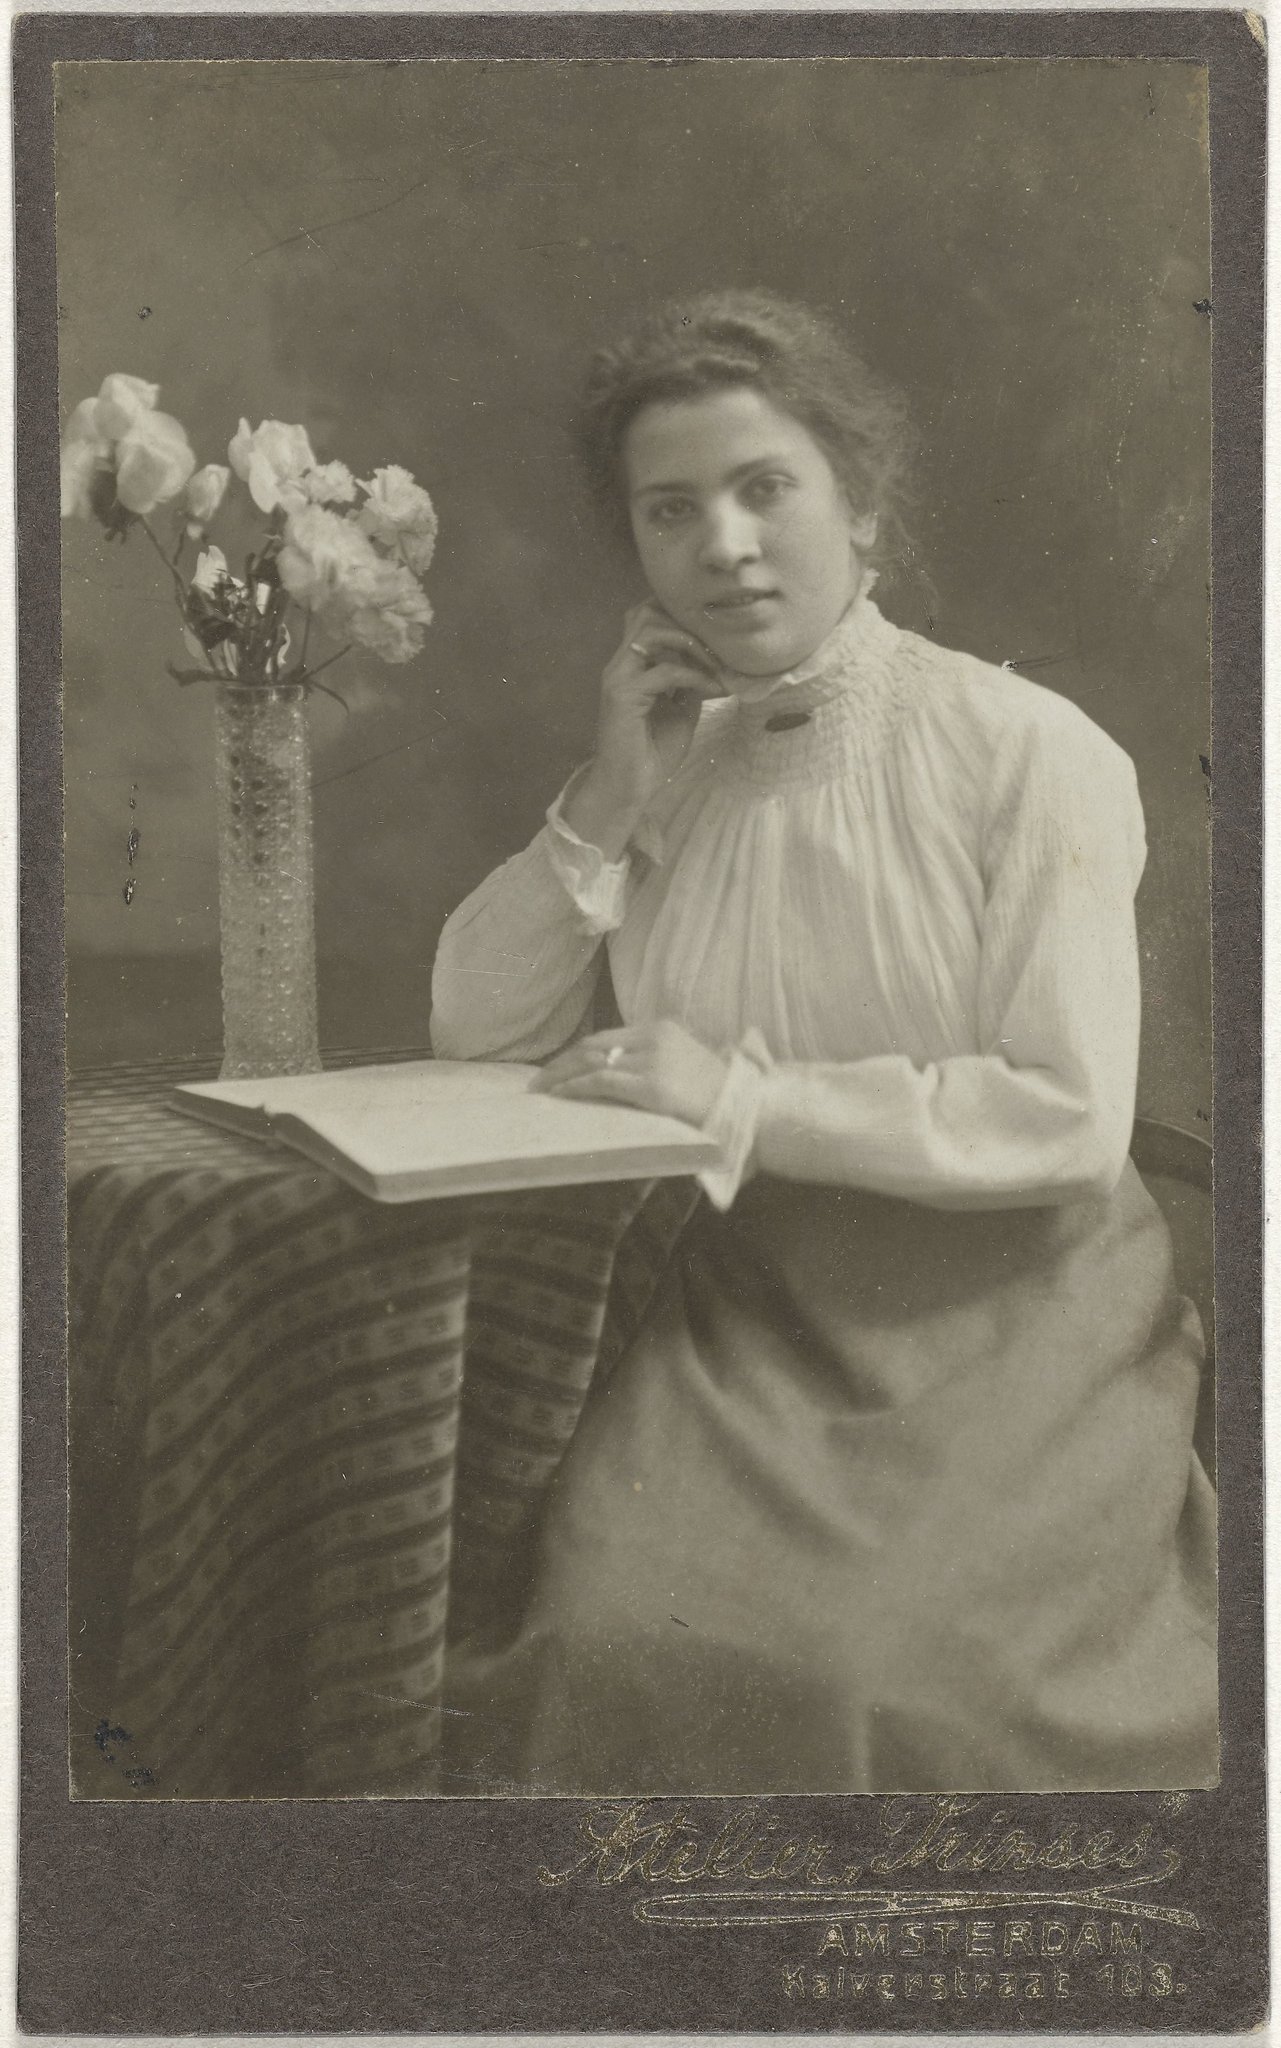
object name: photograph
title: Studioportret van jongedame in hooggesloten jurk lezend aan tafel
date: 1916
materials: photographic support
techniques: albumen print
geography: amsterdam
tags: amsterdam